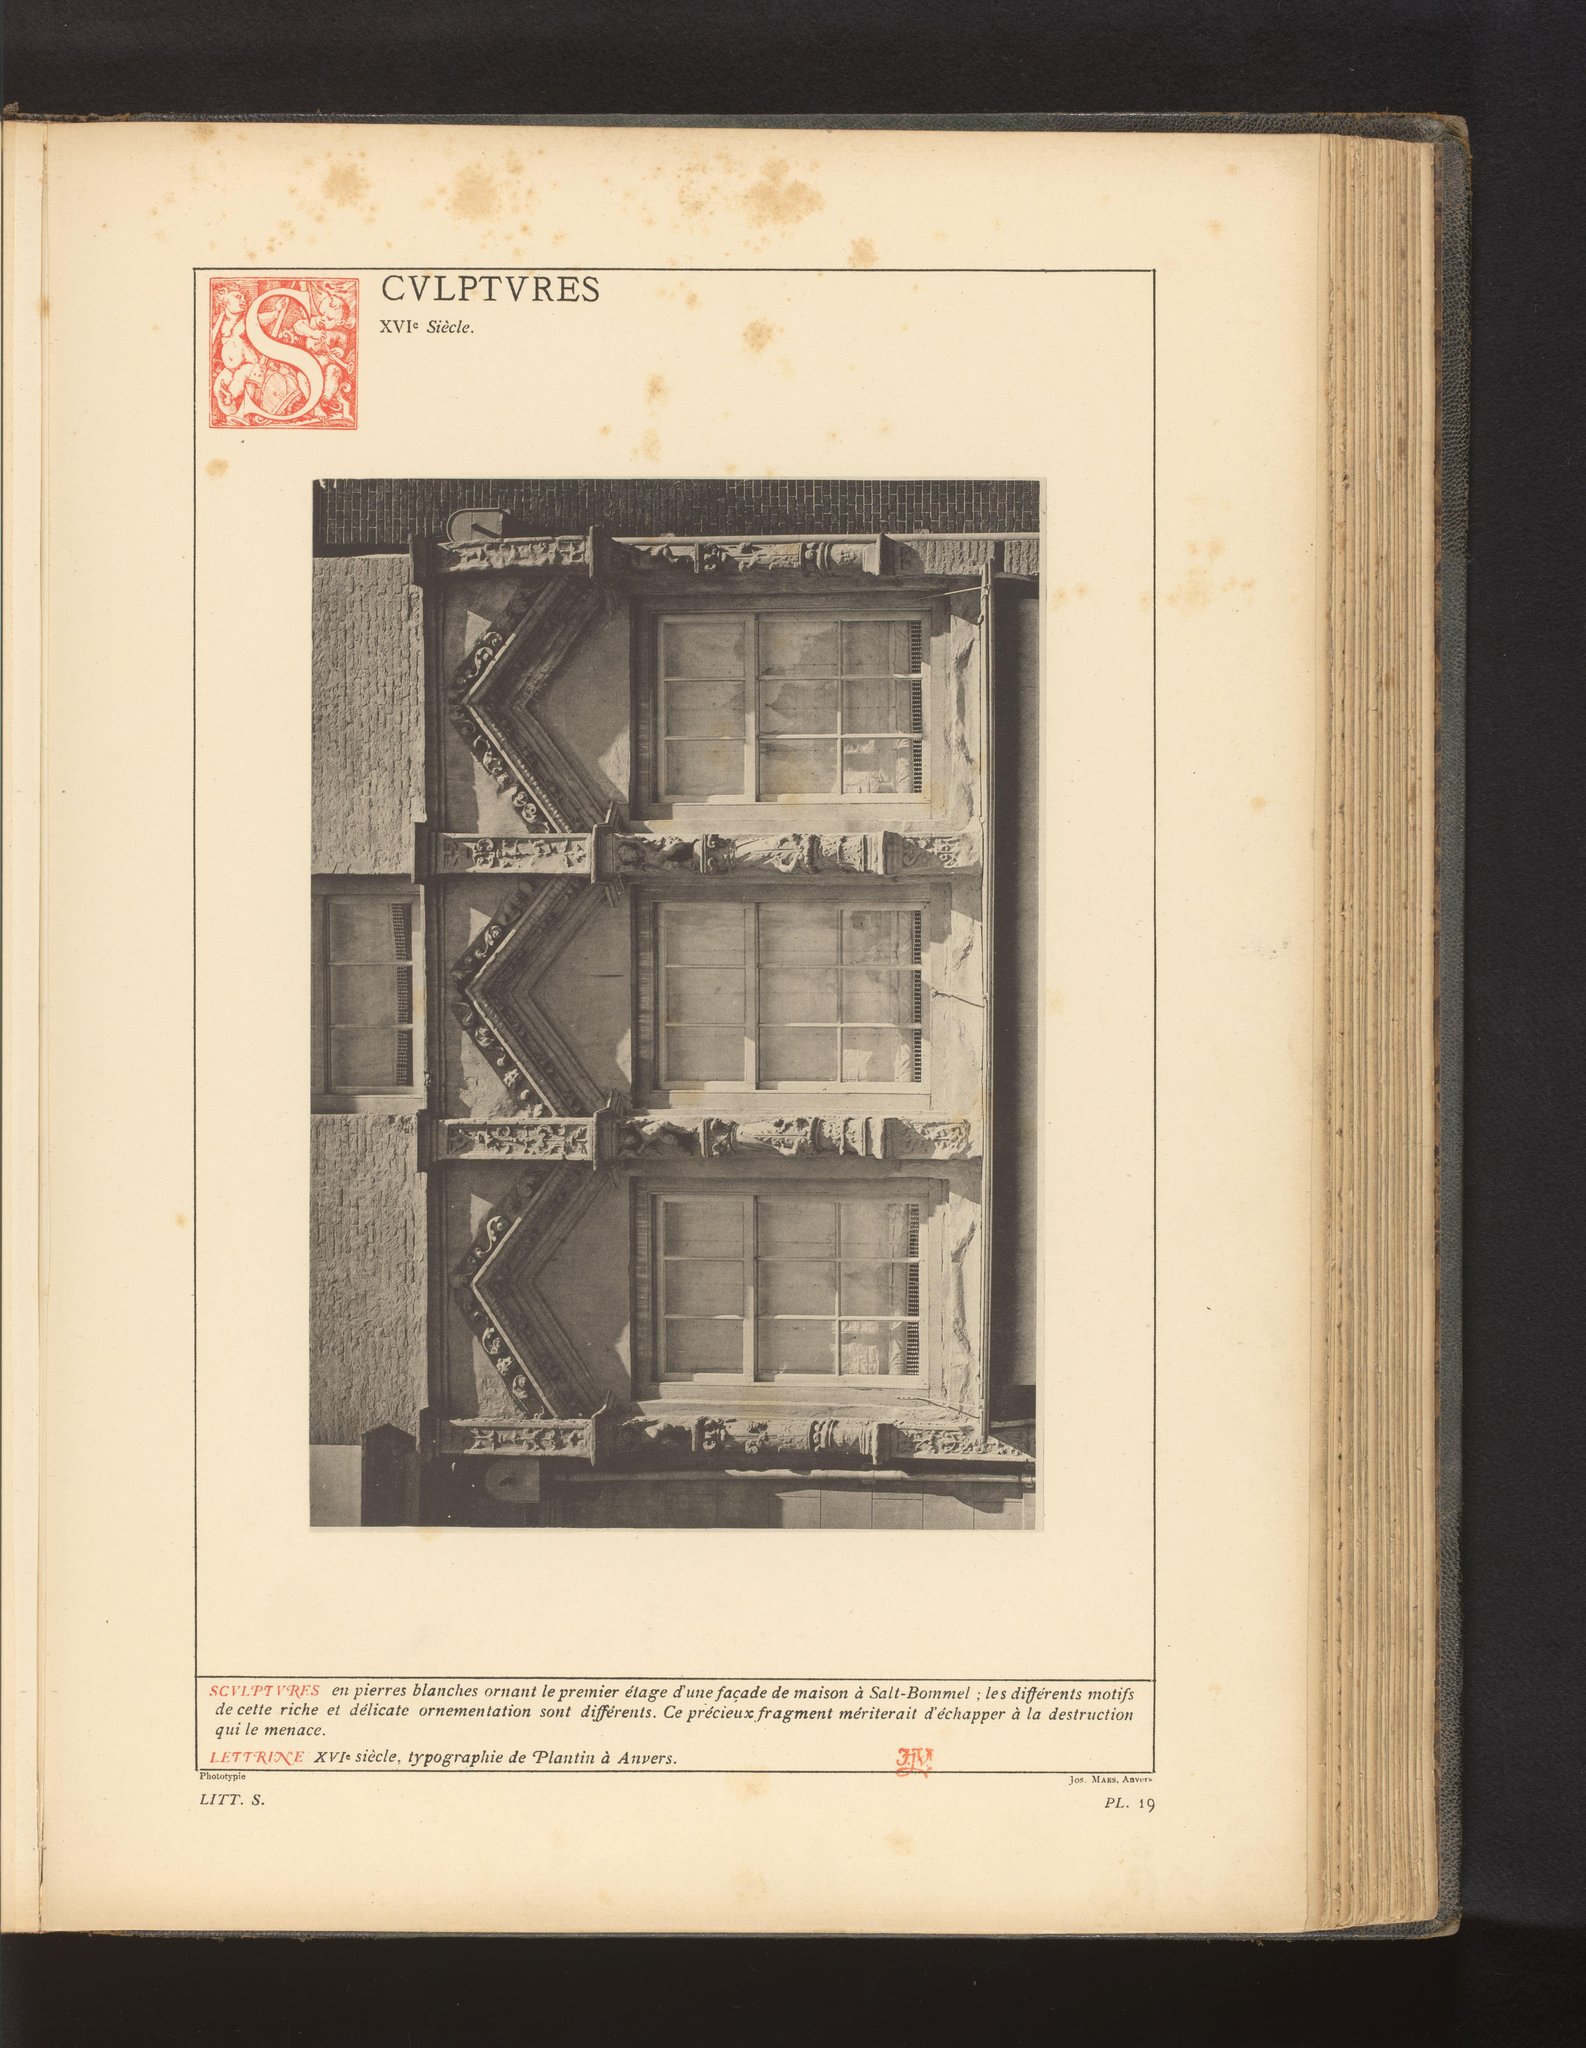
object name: page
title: Sculptures, XVIe Siècle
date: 1876-1881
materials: paper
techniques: photograph, photolithography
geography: zaltbommel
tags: capital (~ column, pillar), front façade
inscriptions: inscription: ‘LITT. S. - PL. 19.’, inscription: ‘SCULPTURES en pierres (...)’, monogram: ‘JJvY’